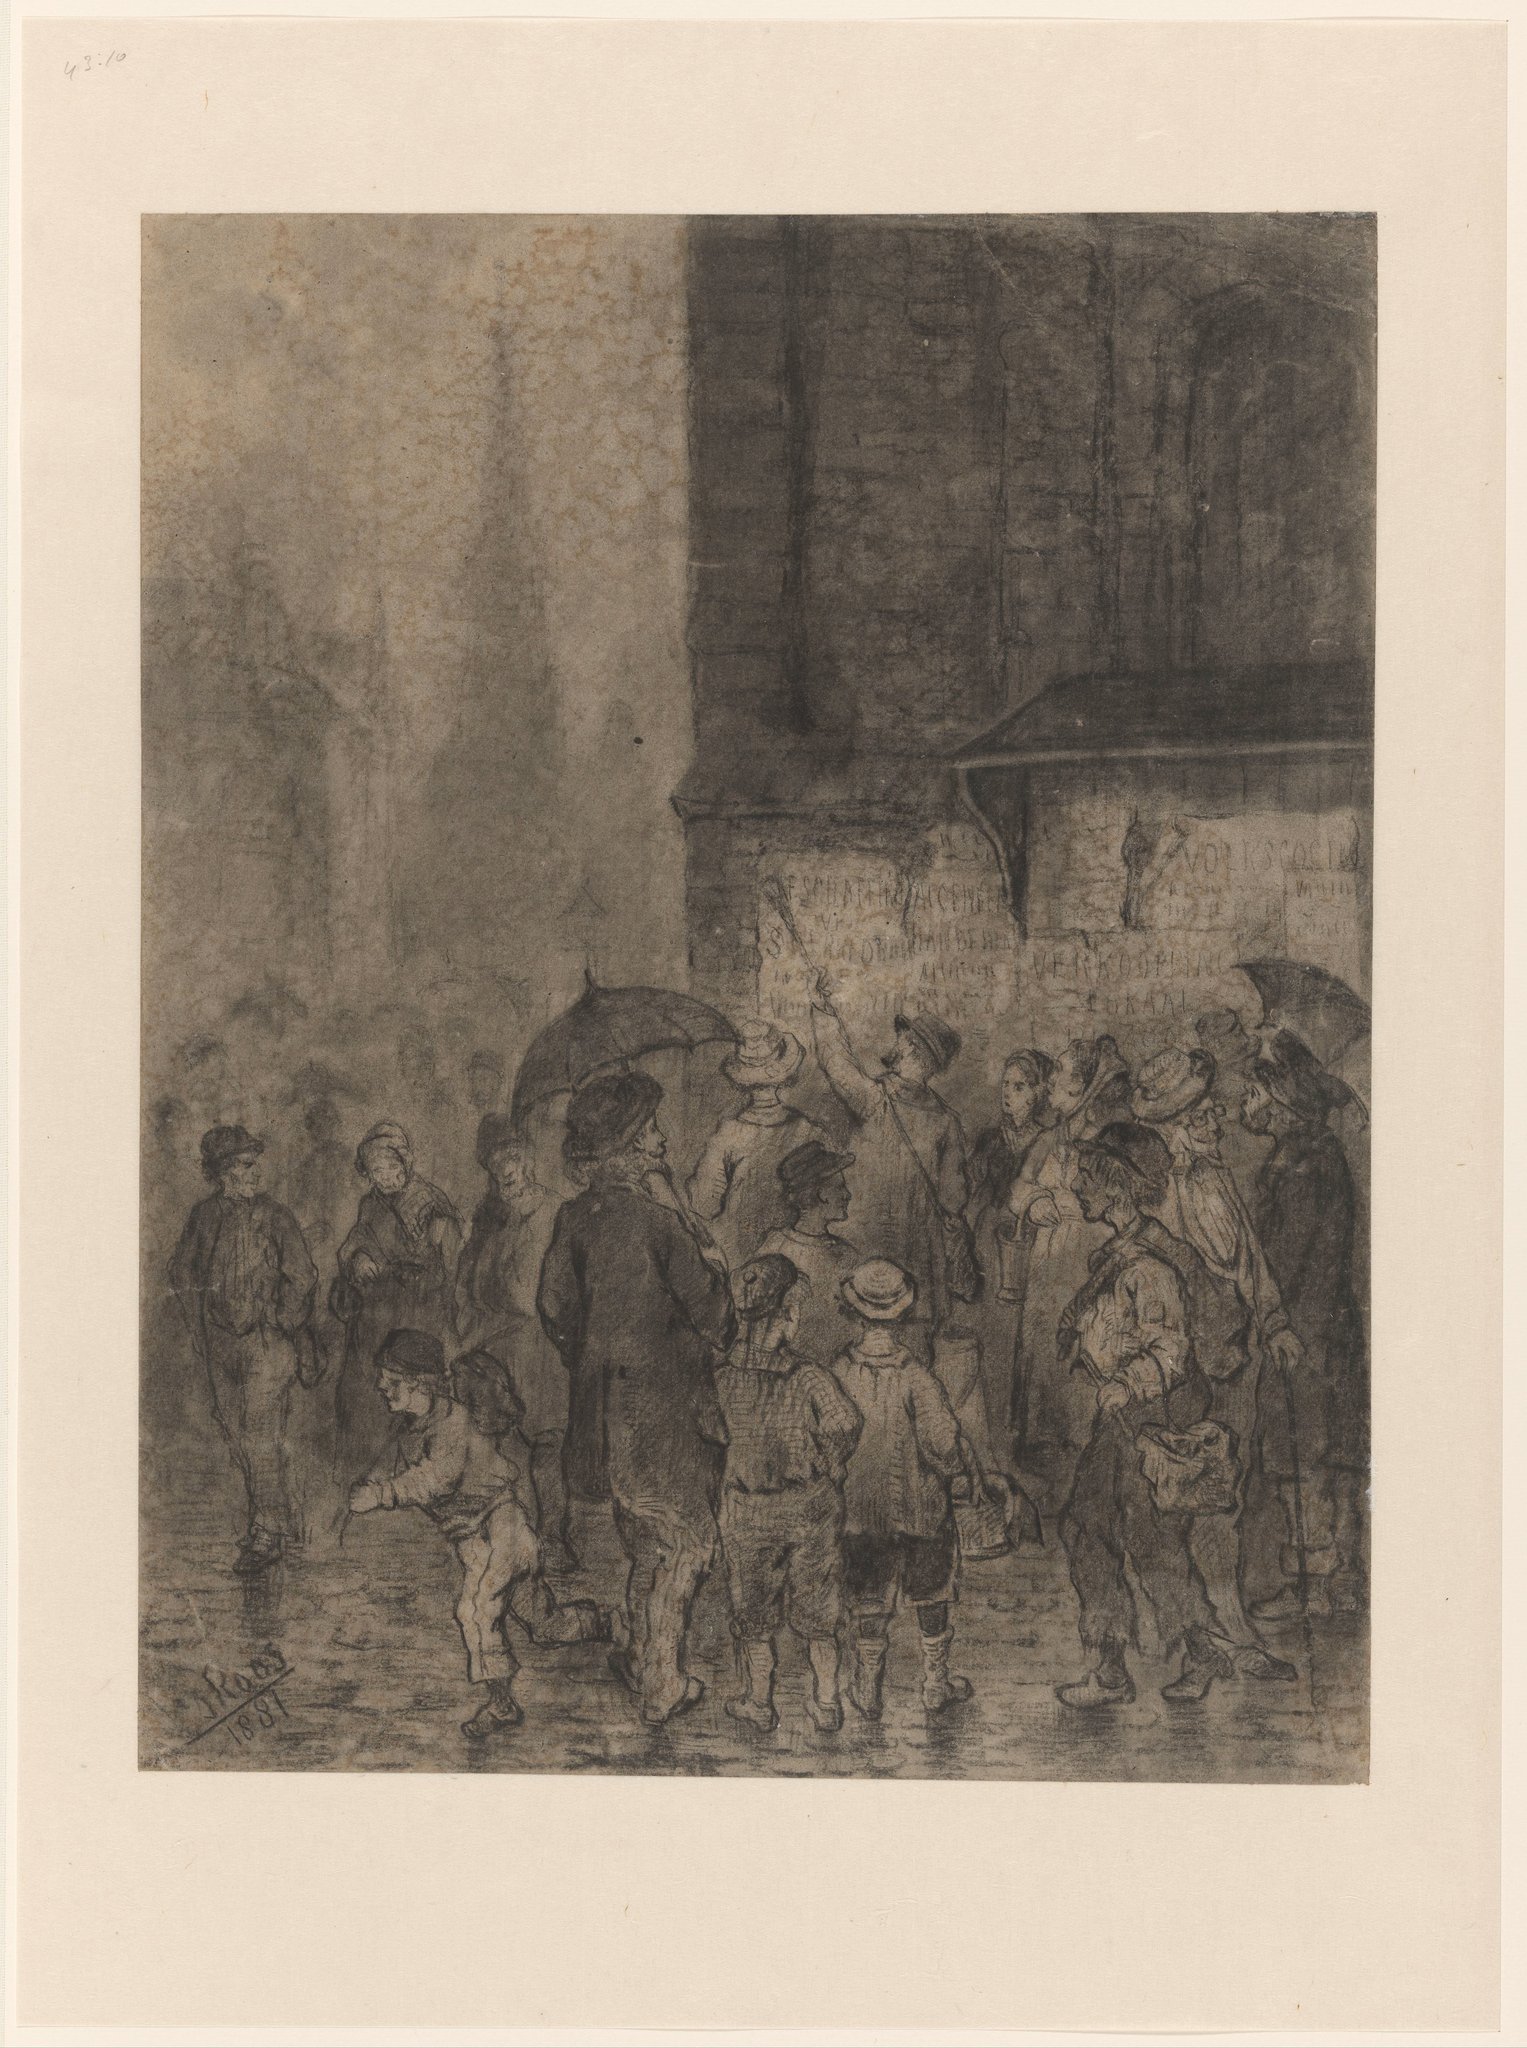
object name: drawing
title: De stadsaanplakker, te Amsterdam bij regen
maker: cornelis stephanus roos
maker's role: draughtsman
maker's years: 1845-1882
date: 1881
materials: chalk, paper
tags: street, poster, amsterdam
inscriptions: date: ‘1881’